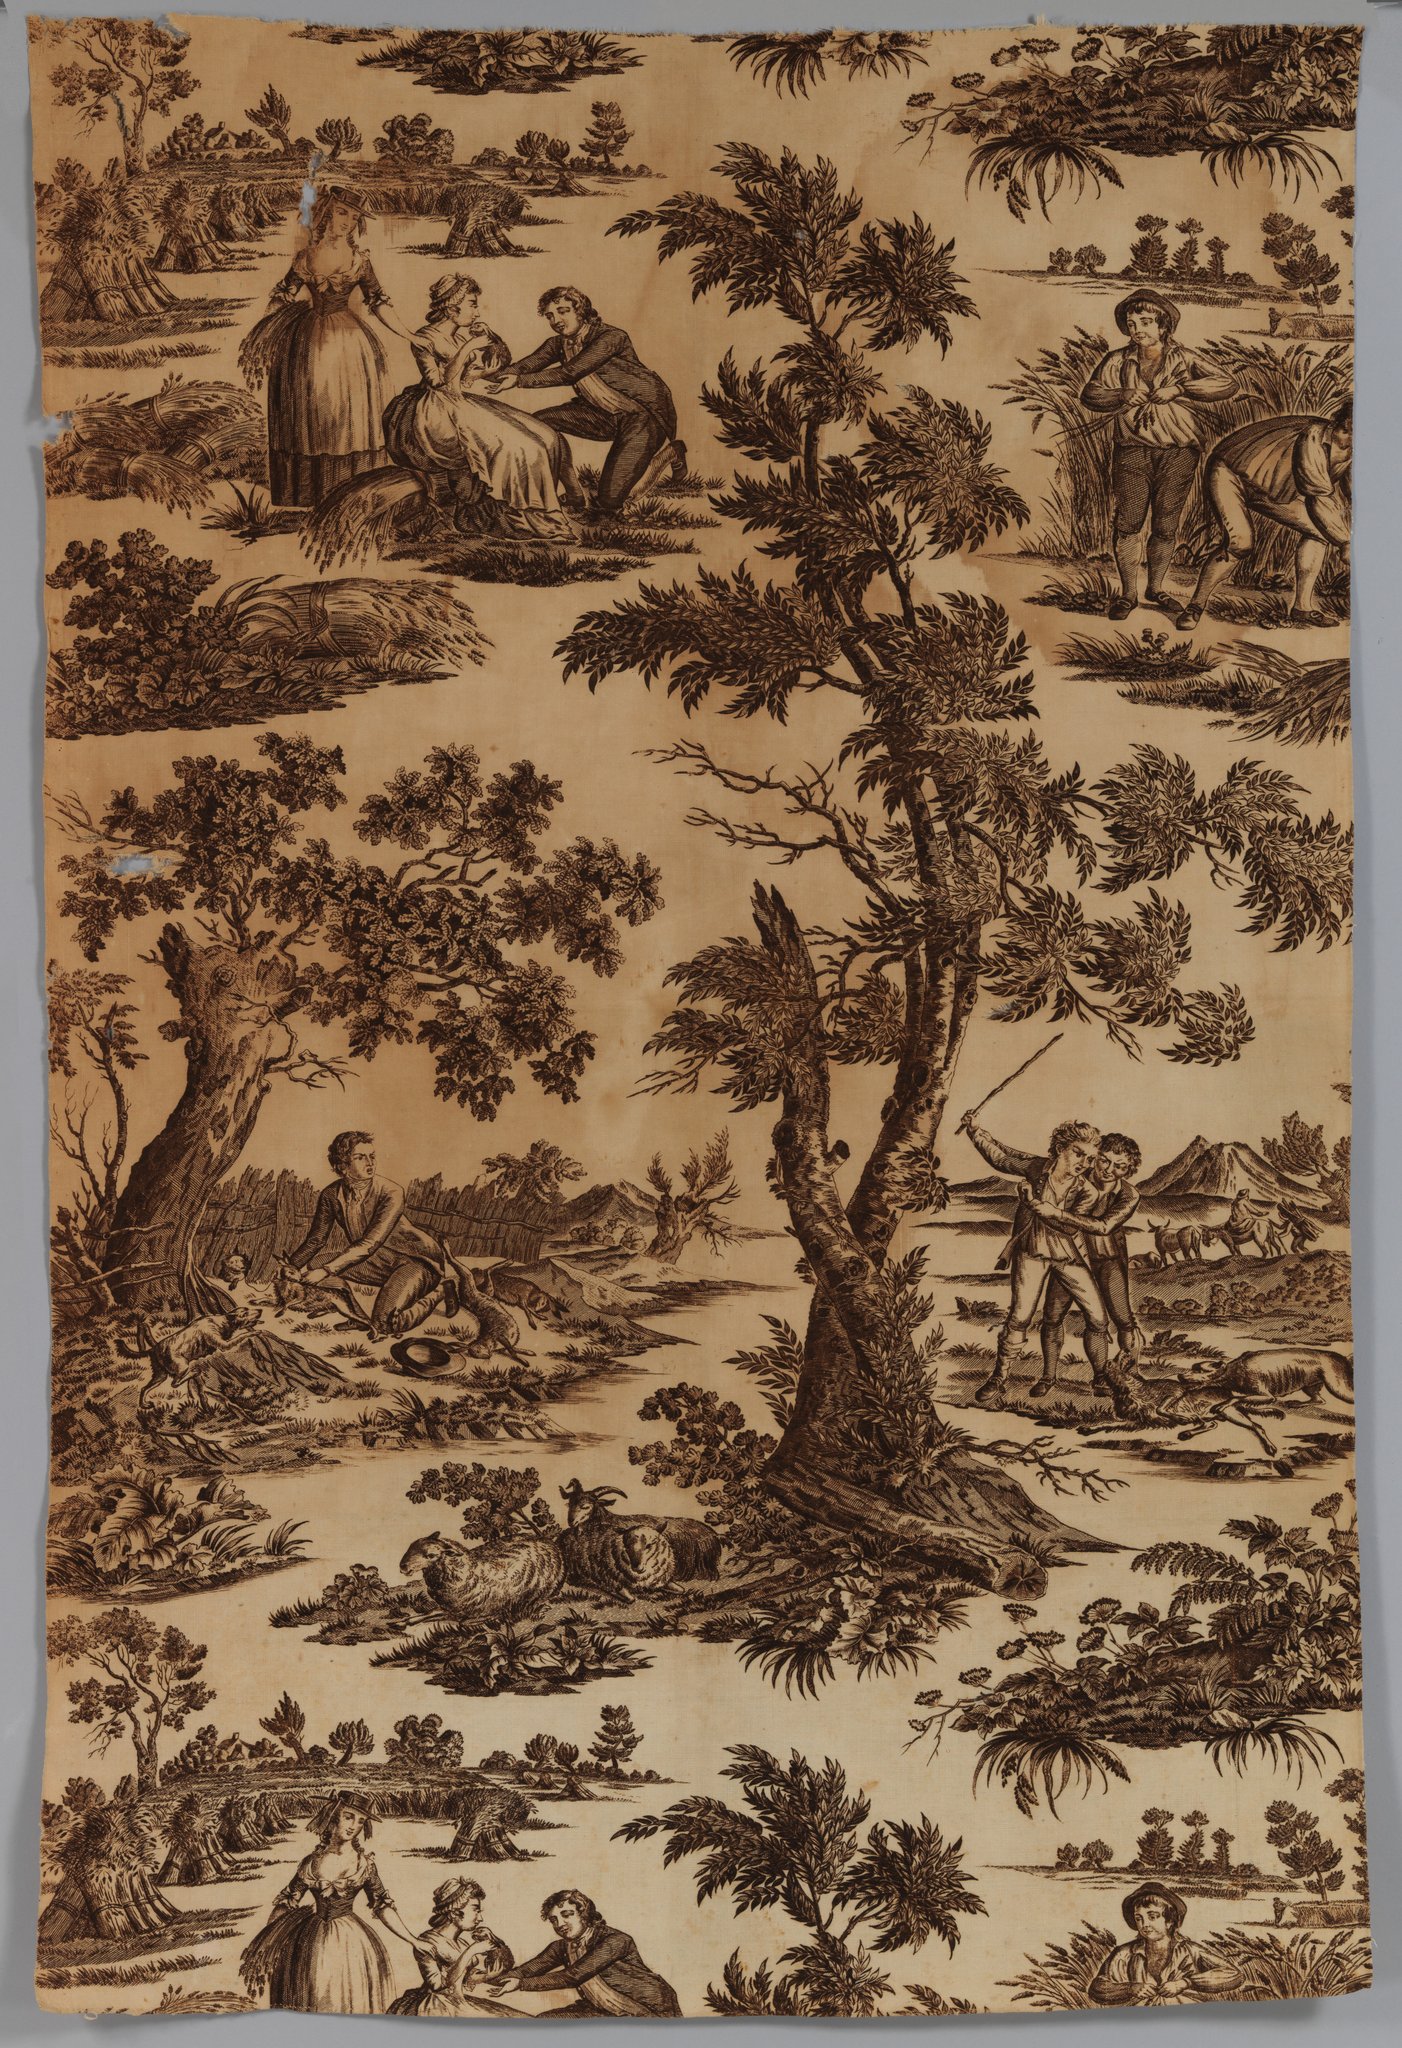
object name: piece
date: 1790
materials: cotton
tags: men,women,dogs,rabbits,sheep,trees